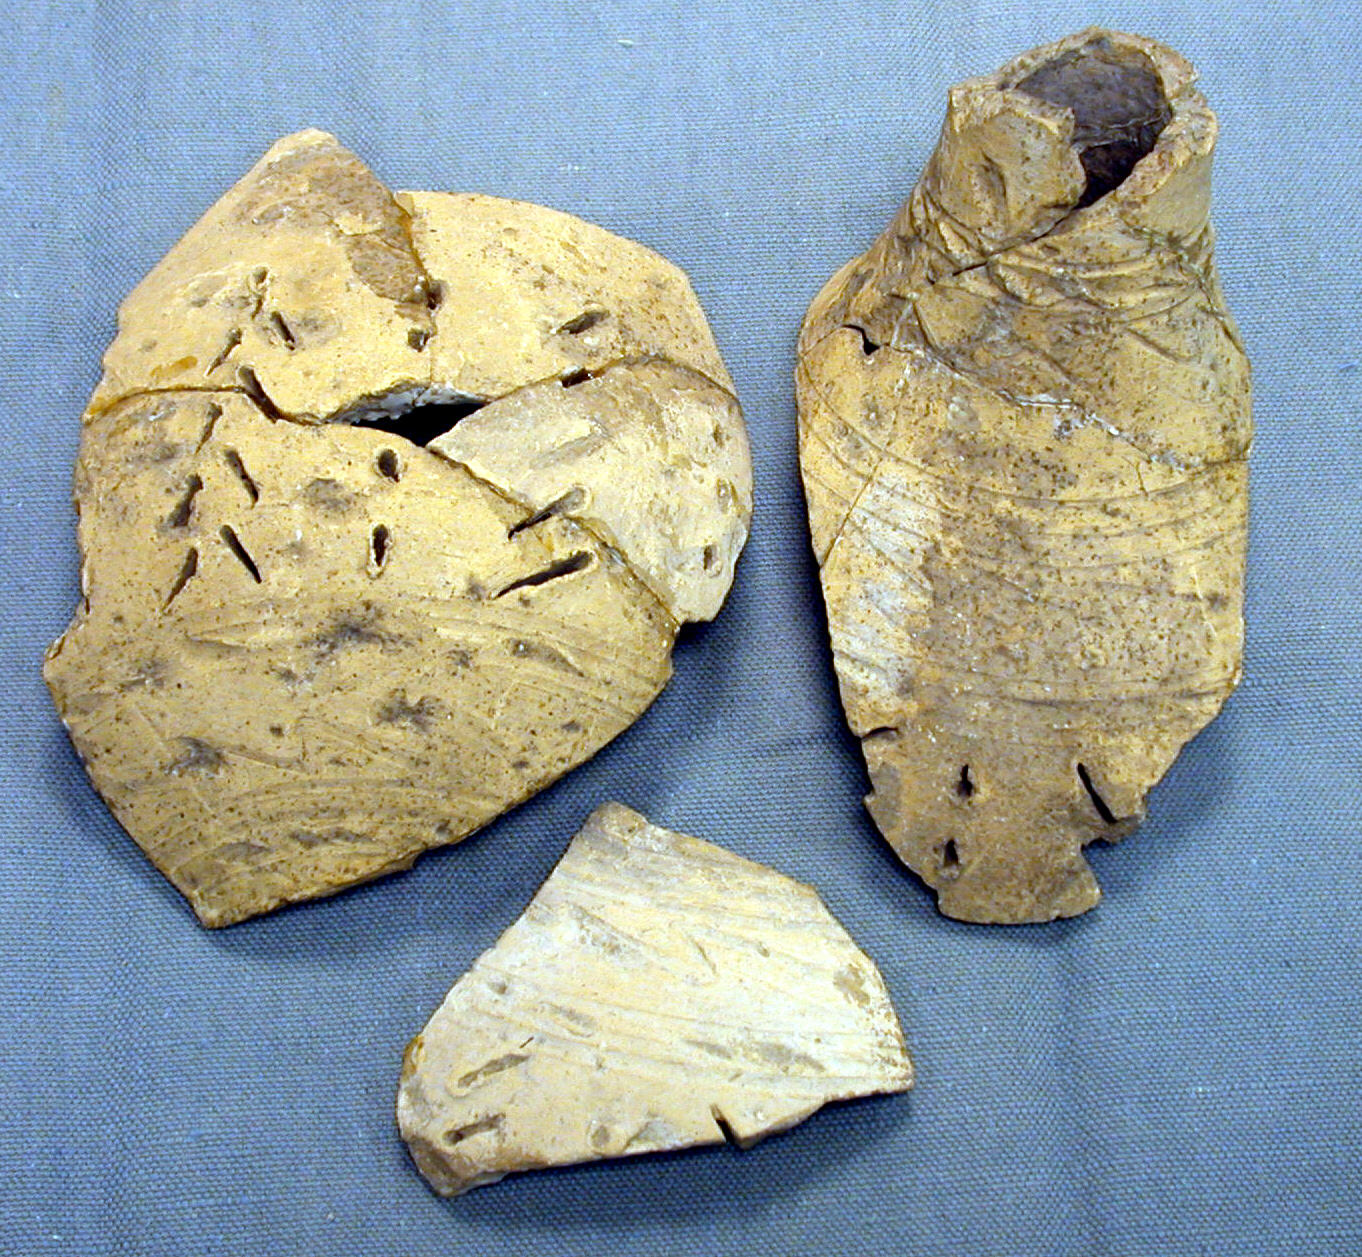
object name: lantern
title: Lantern sherds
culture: islamic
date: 801-1000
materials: ceramic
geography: iran